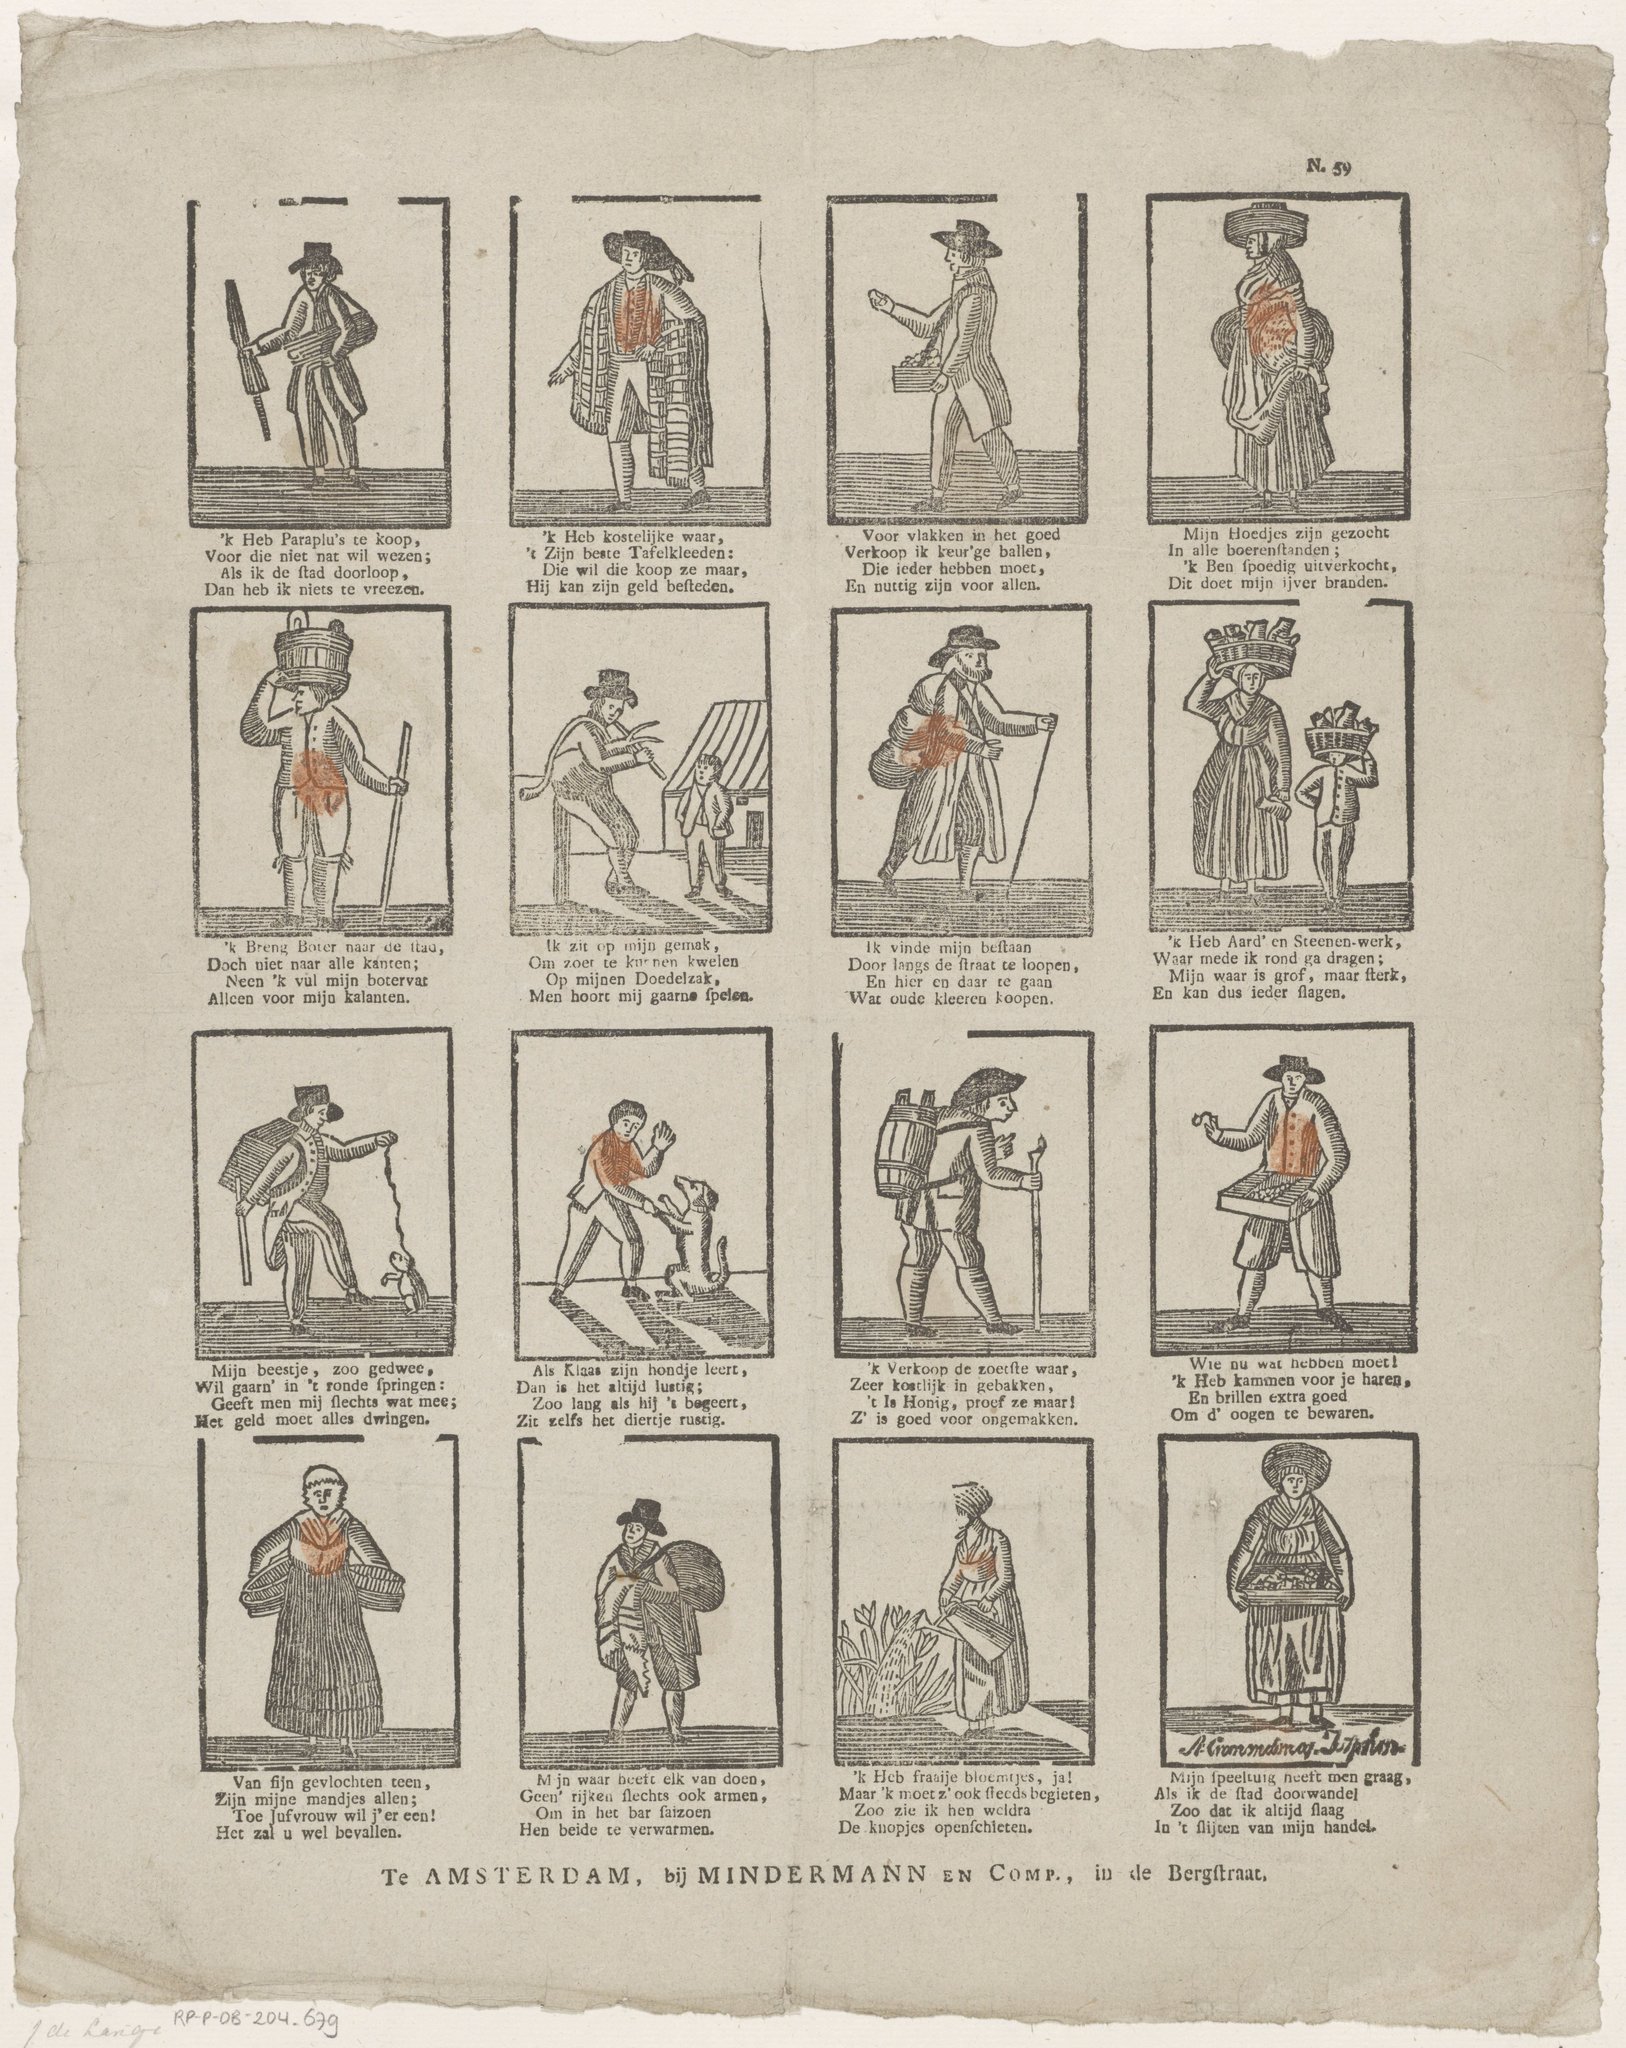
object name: popular print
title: Figuren en beroepen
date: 1822-1849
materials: paper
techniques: colour, letterpress printing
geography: deventer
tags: musician at work, human types, street-trader, merchant, salesman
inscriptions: collector's mark: Lugt 2760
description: Blad met 16 voorstellingen van figuren en beroepen, zoals een straatverkoper, een doedelzakspeler en een vrouw die de planten water geeft. Onder elke afbeelding een vierregelig vers. Genummerd rechtsboven: N 59.